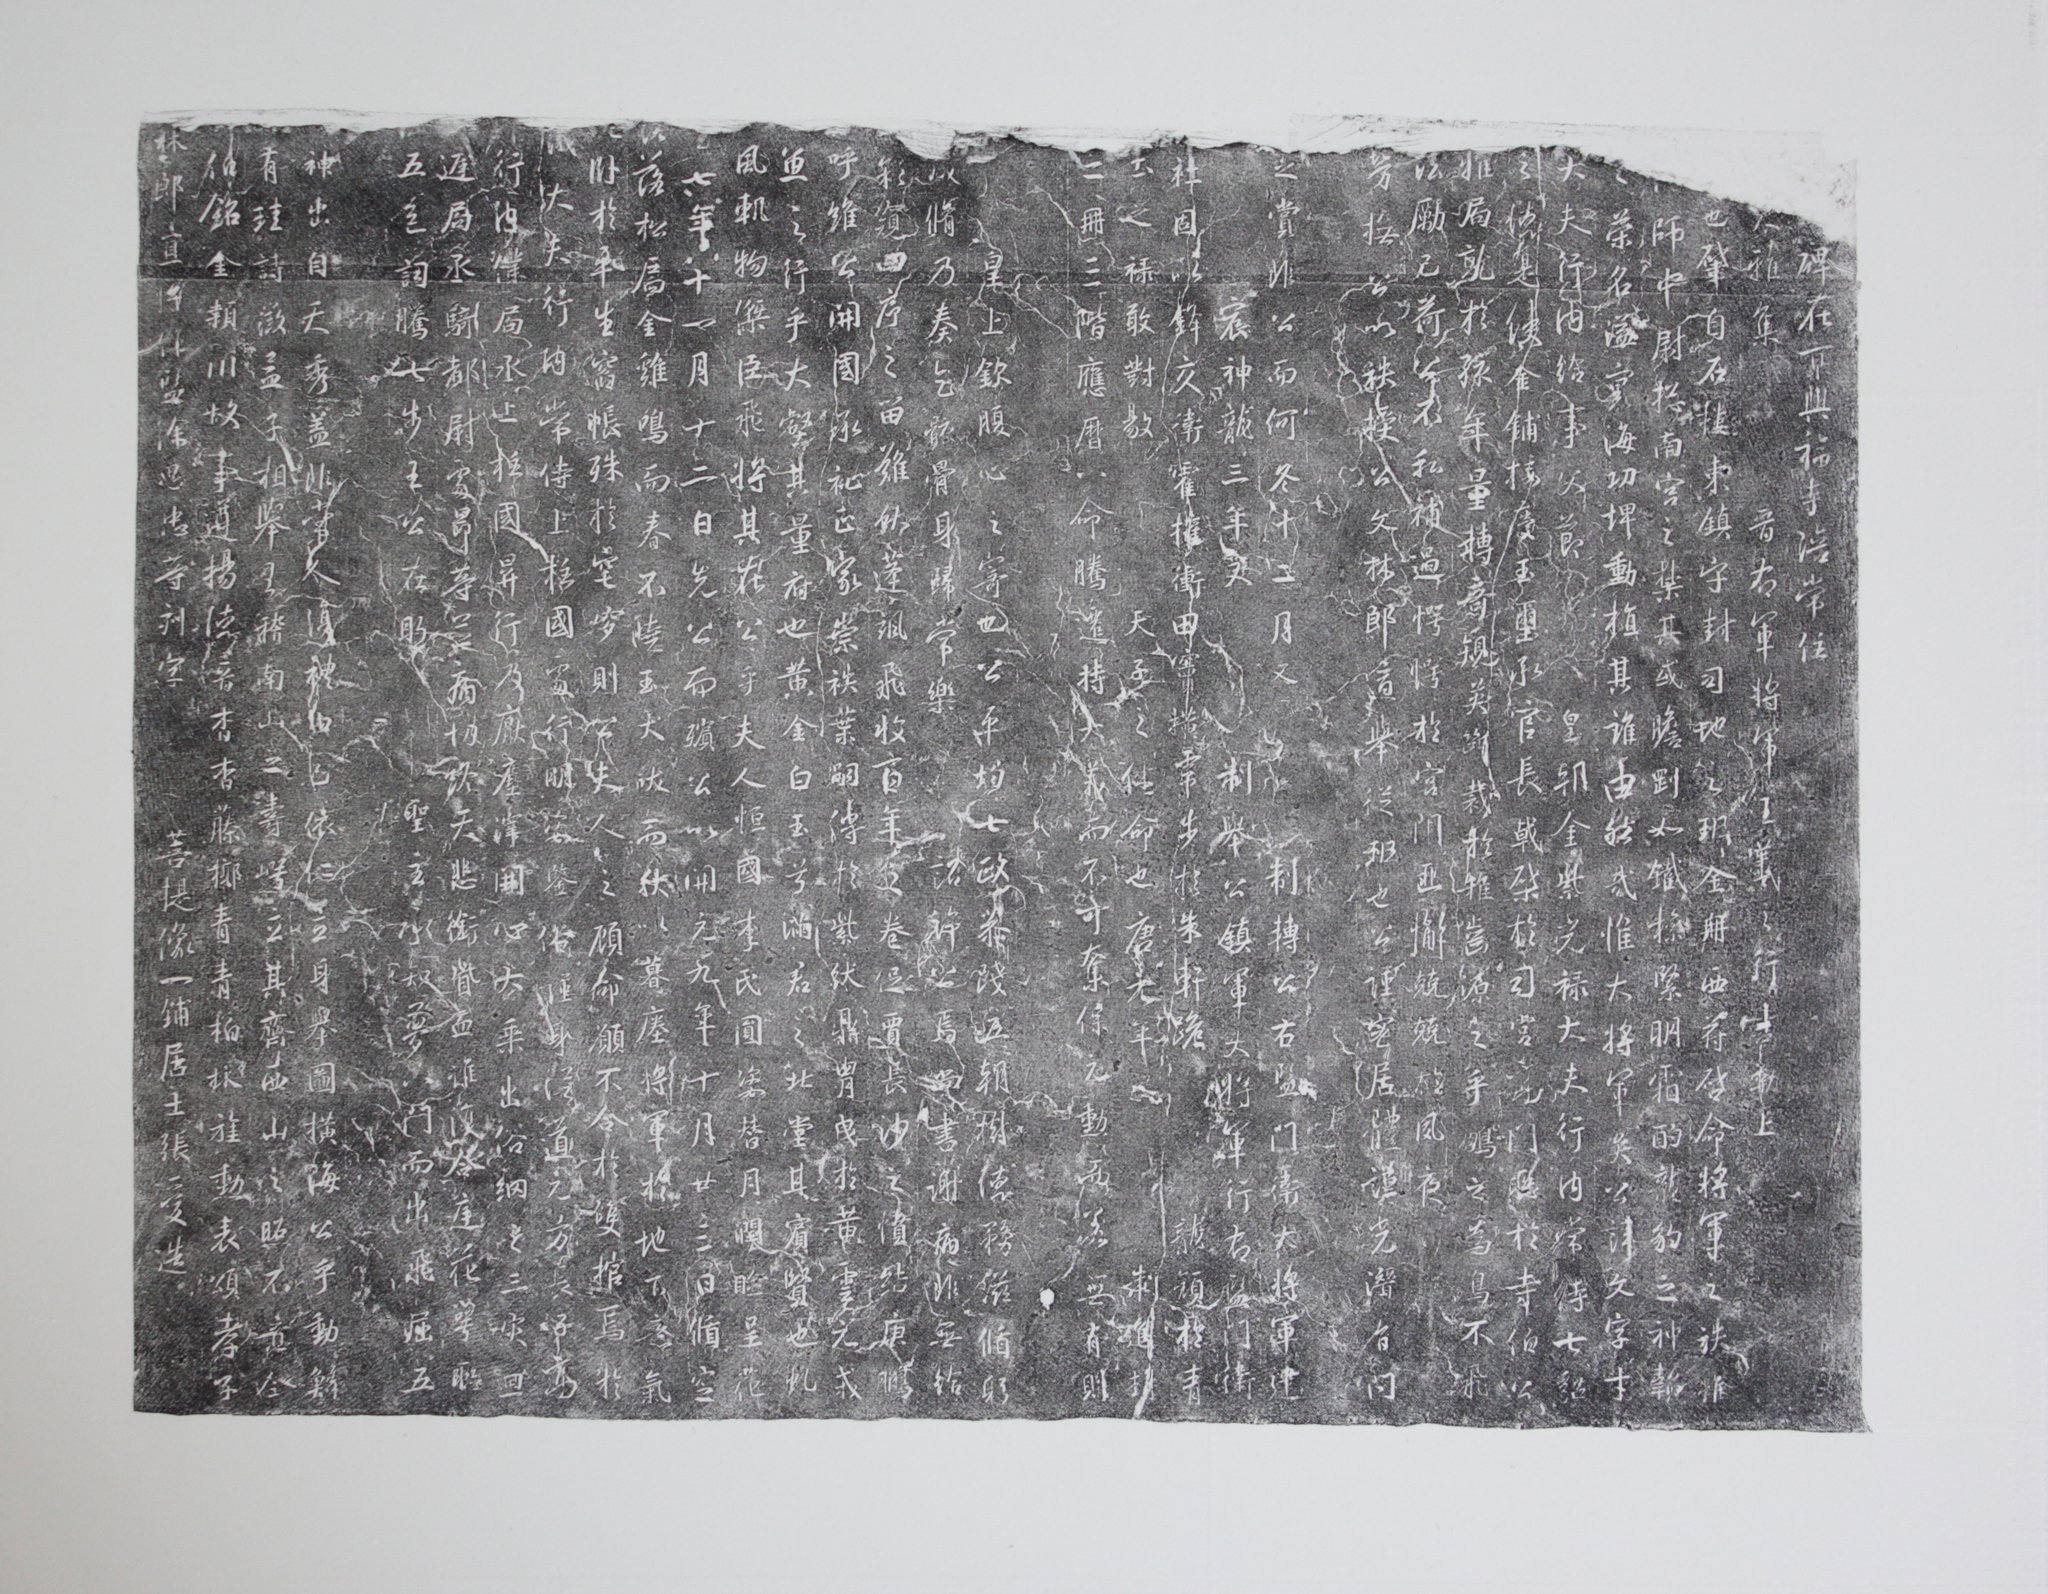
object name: rubbing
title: Stele Compiled by the Monk Daya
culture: chinese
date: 1901-2000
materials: ink, paper